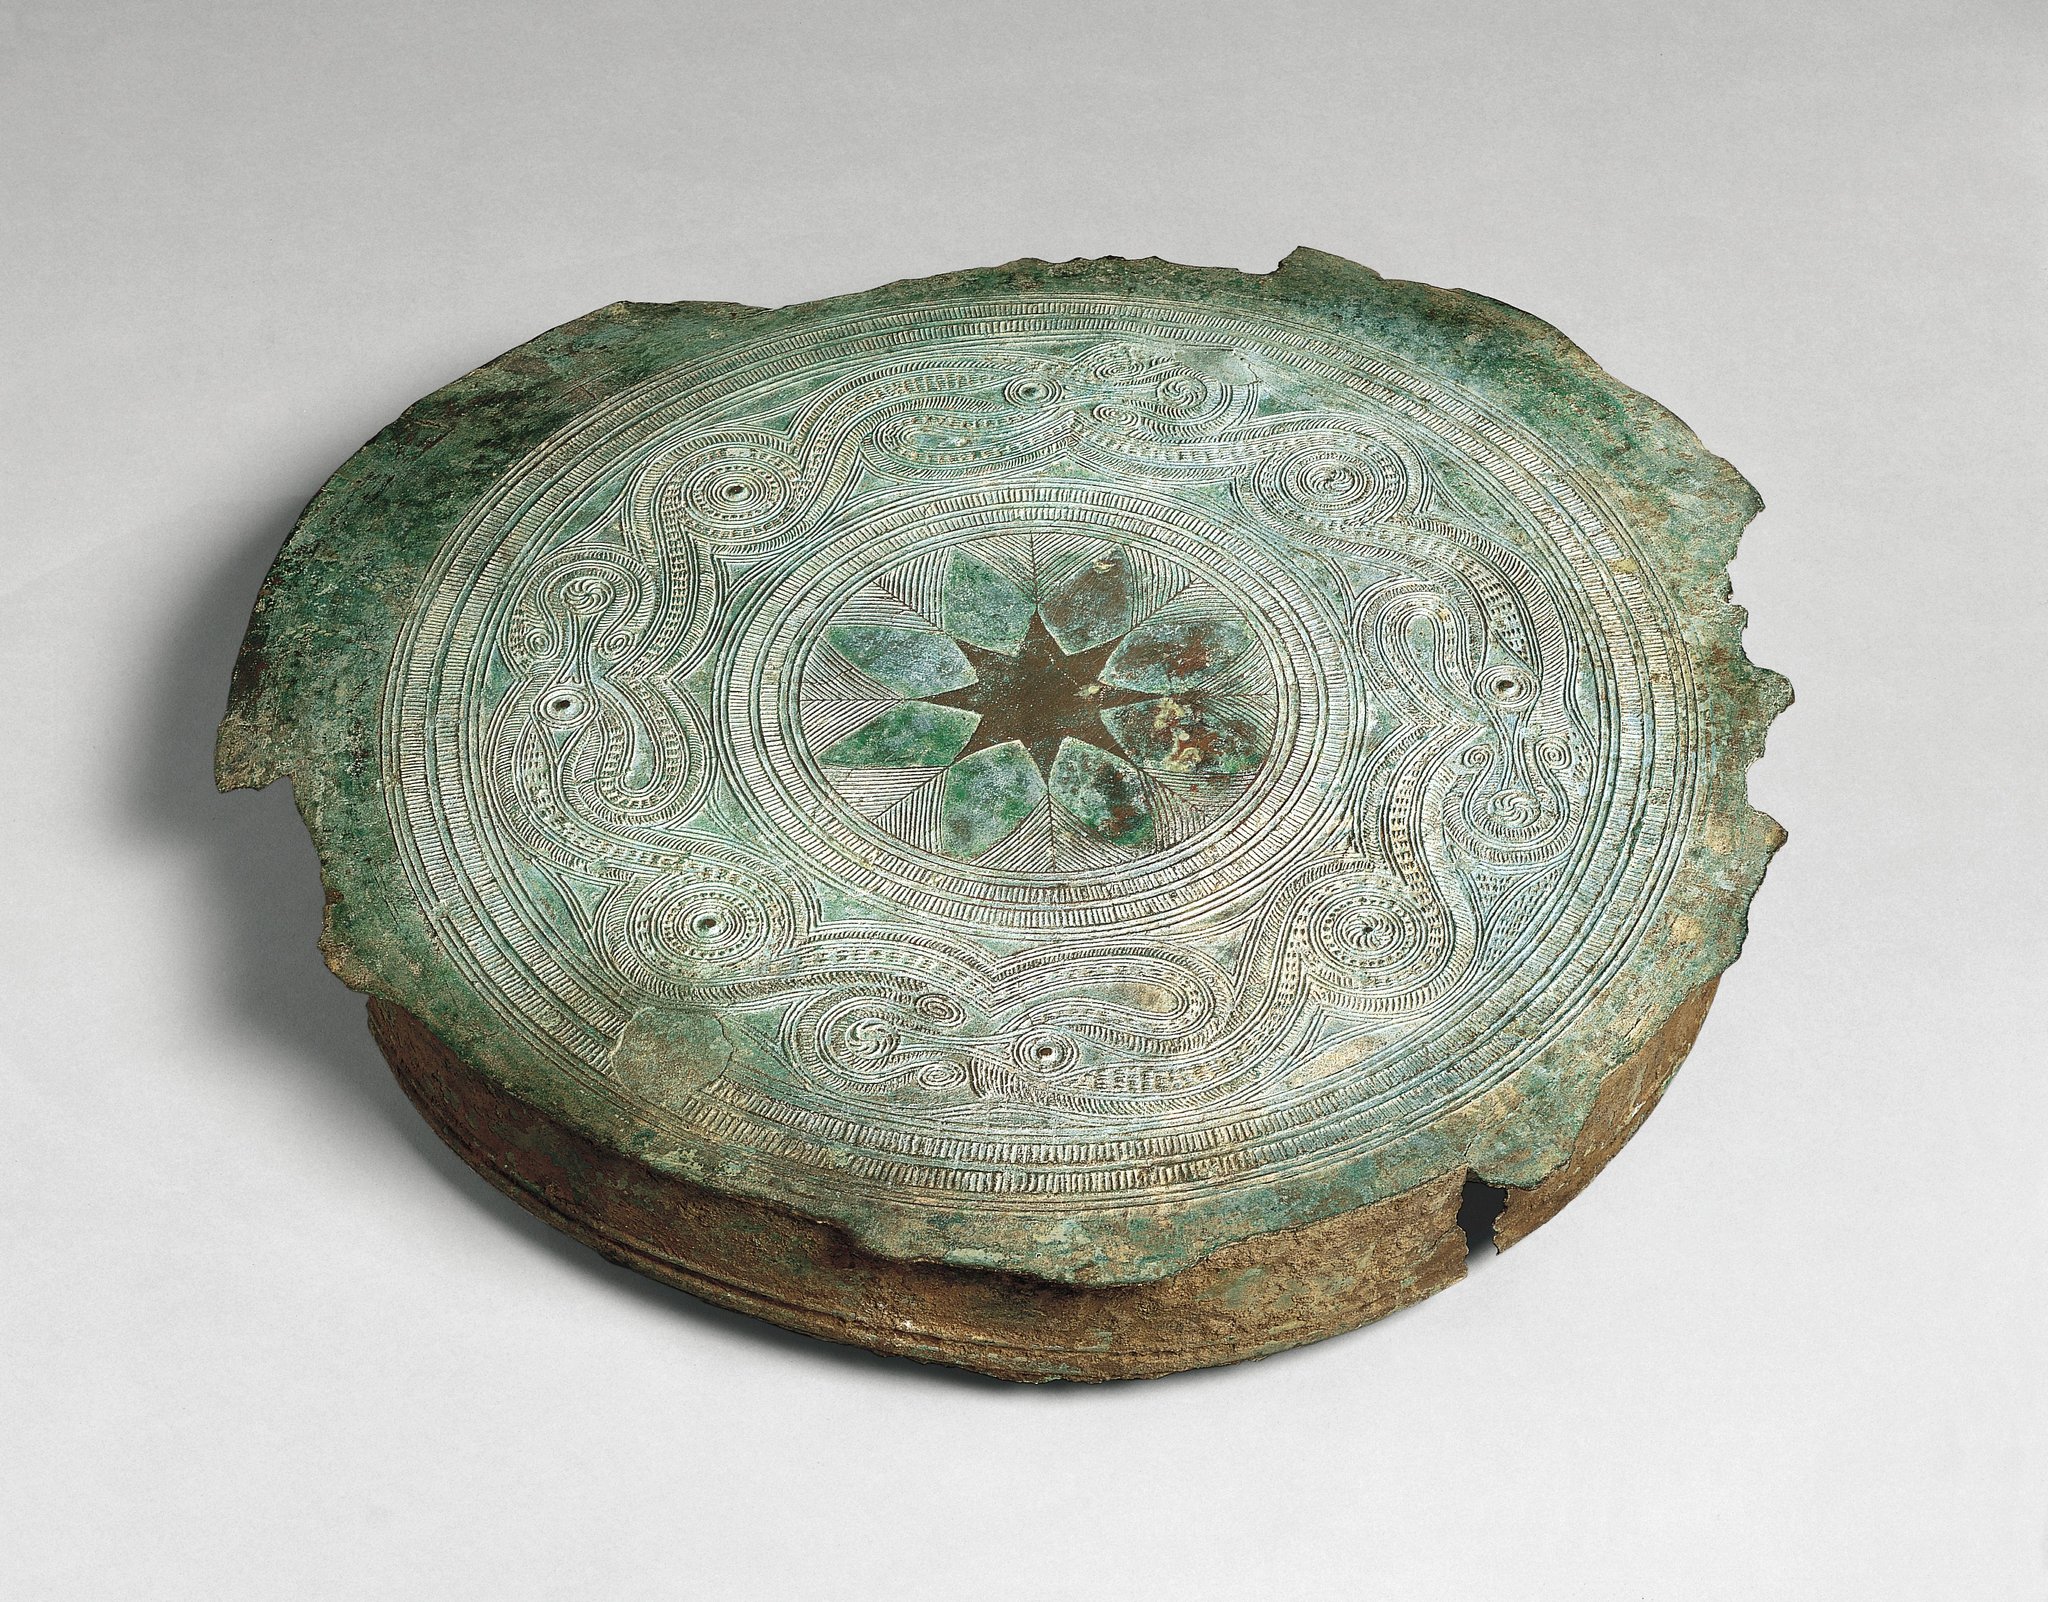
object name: tympanum of a pejeng type drum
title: Tympanum of a Pejeng-Type Drum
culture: indonesian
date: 500 BCE-300 CE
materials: bronze